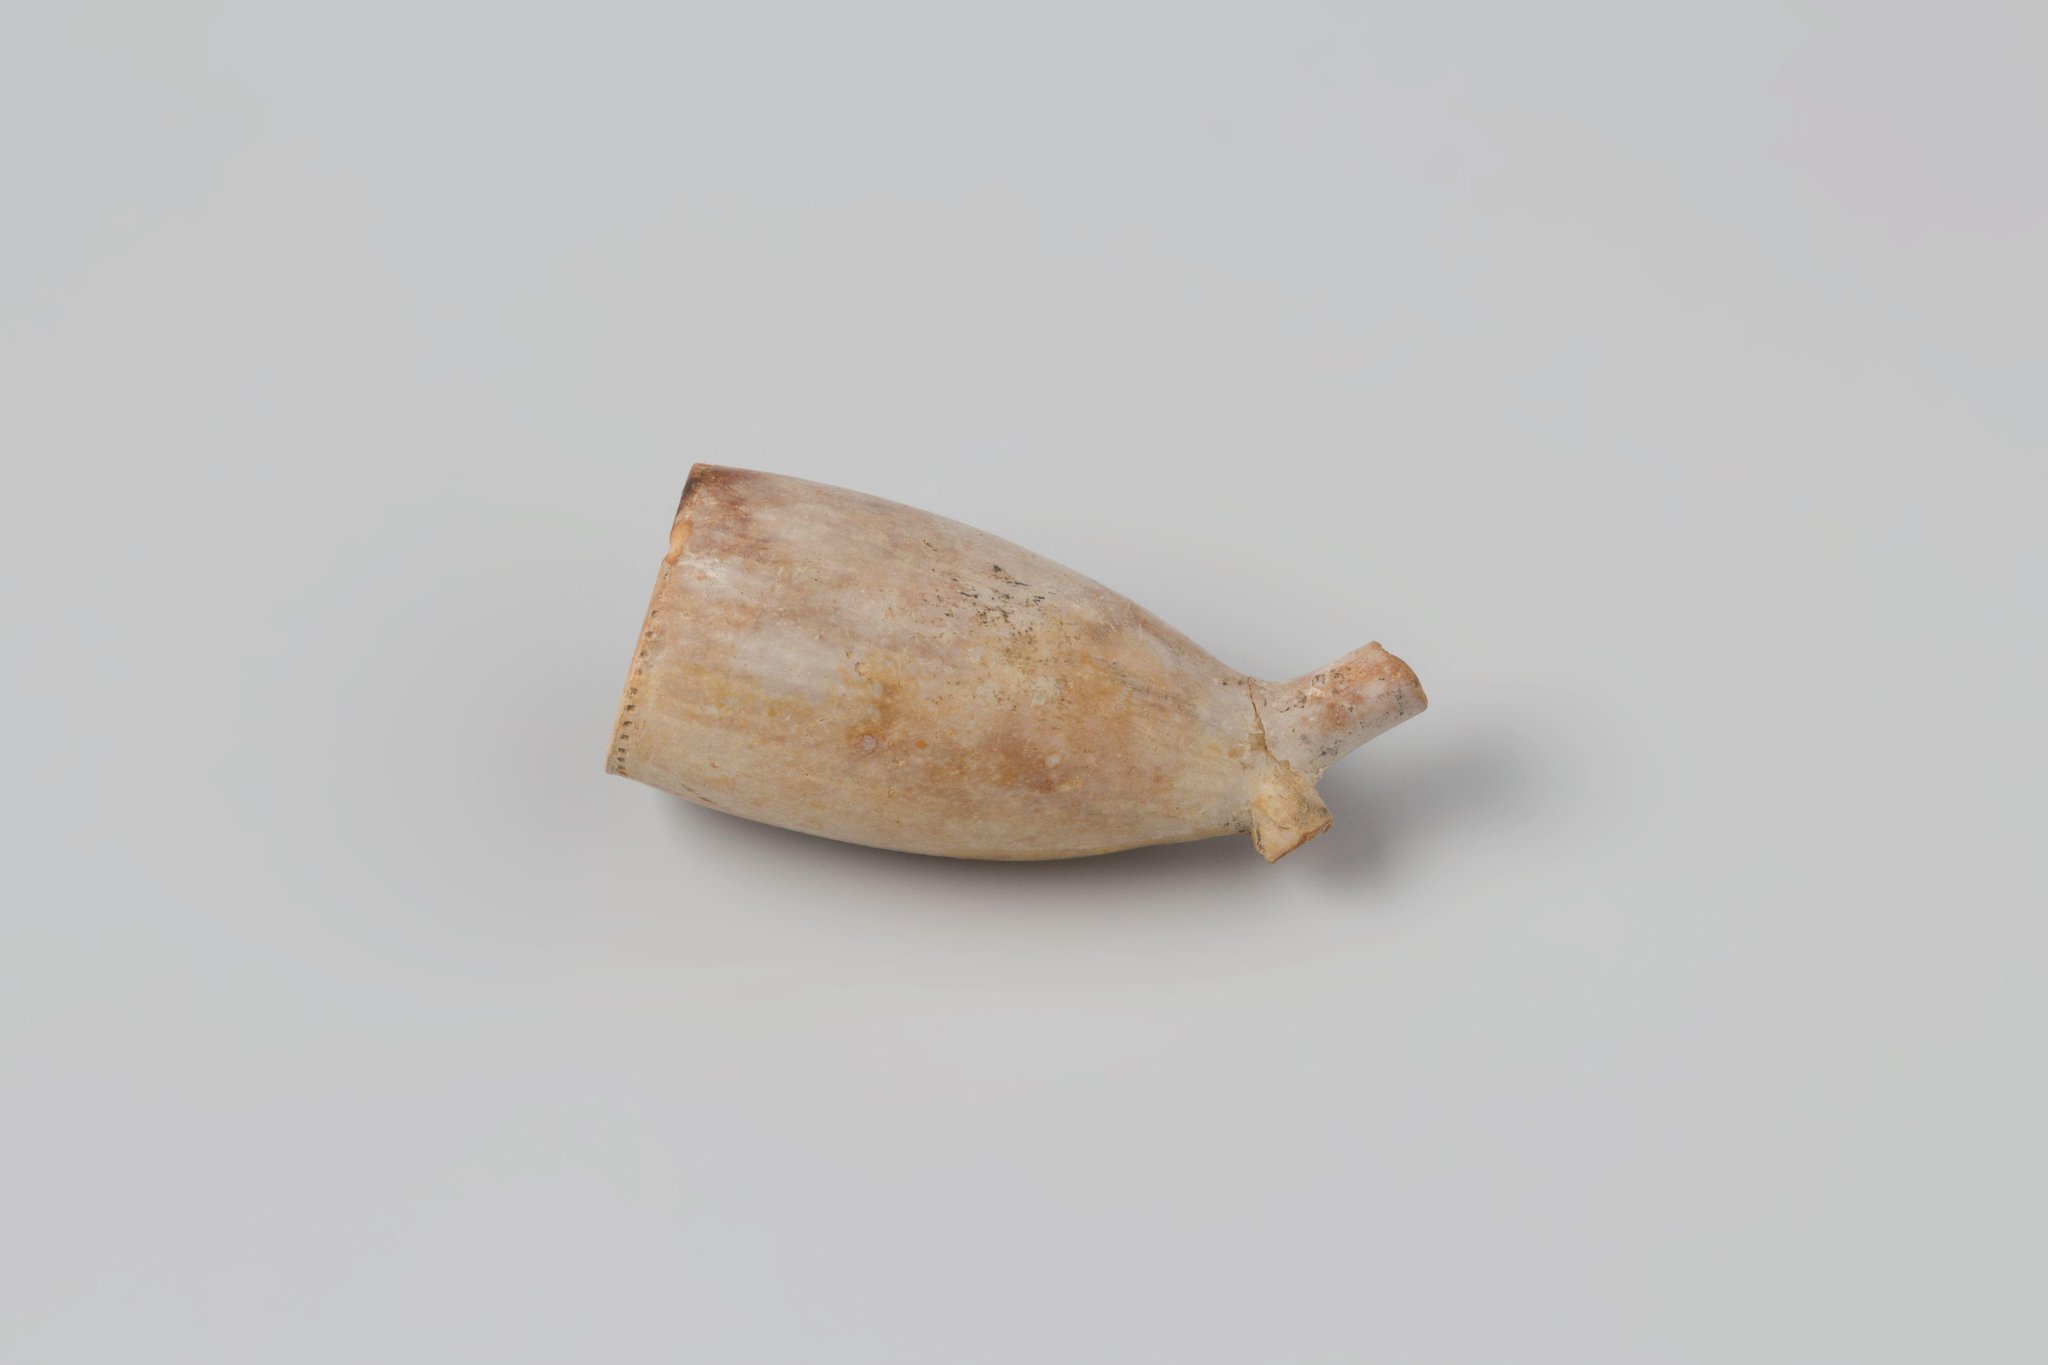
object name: pipe bowl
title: Pijpenkop uit het wrak van de Oost-Indiëvaarder Hollandia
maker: Anonymous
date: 1700-1743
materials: clay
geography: netherlands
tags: verenigde oostindische compagnie, hollandia (schip), annet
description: Pipe, bowl, heelmark: crowned 91; 1hsm1.